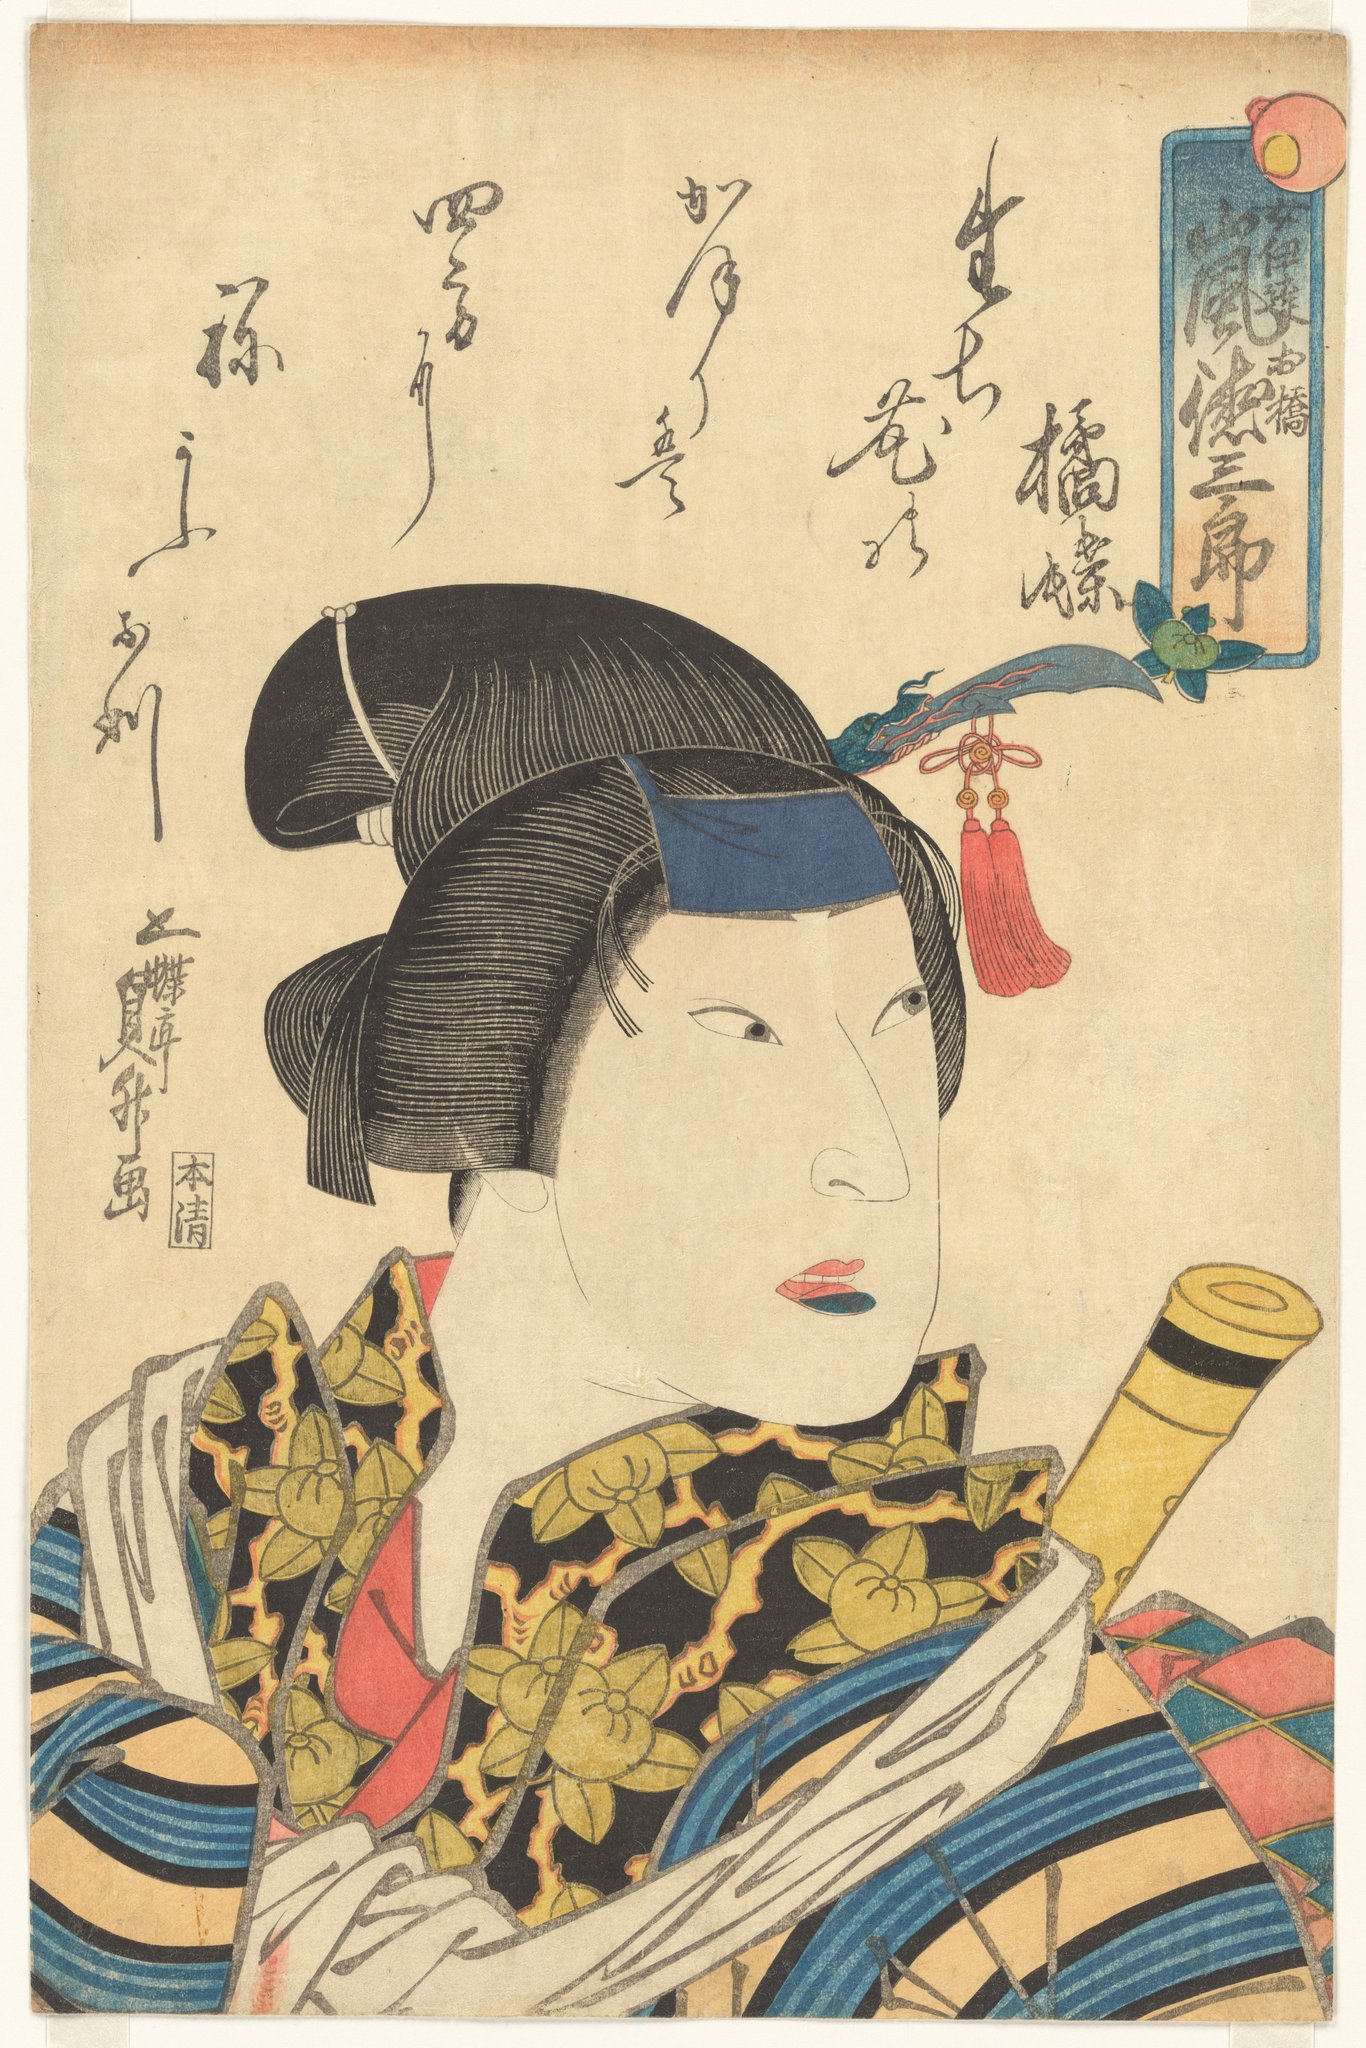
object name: woodblock print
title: The Actor Arashi Tokusaburō as the Female Gallant (Onnadate) Ohashi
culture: japanese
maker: utagawa sadamasu (kunimasu) 初代歌貞升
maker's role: artist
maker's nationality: japanese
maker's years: 1820-1850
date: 1838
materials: ink, paper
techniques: nishiki e, woodblock print